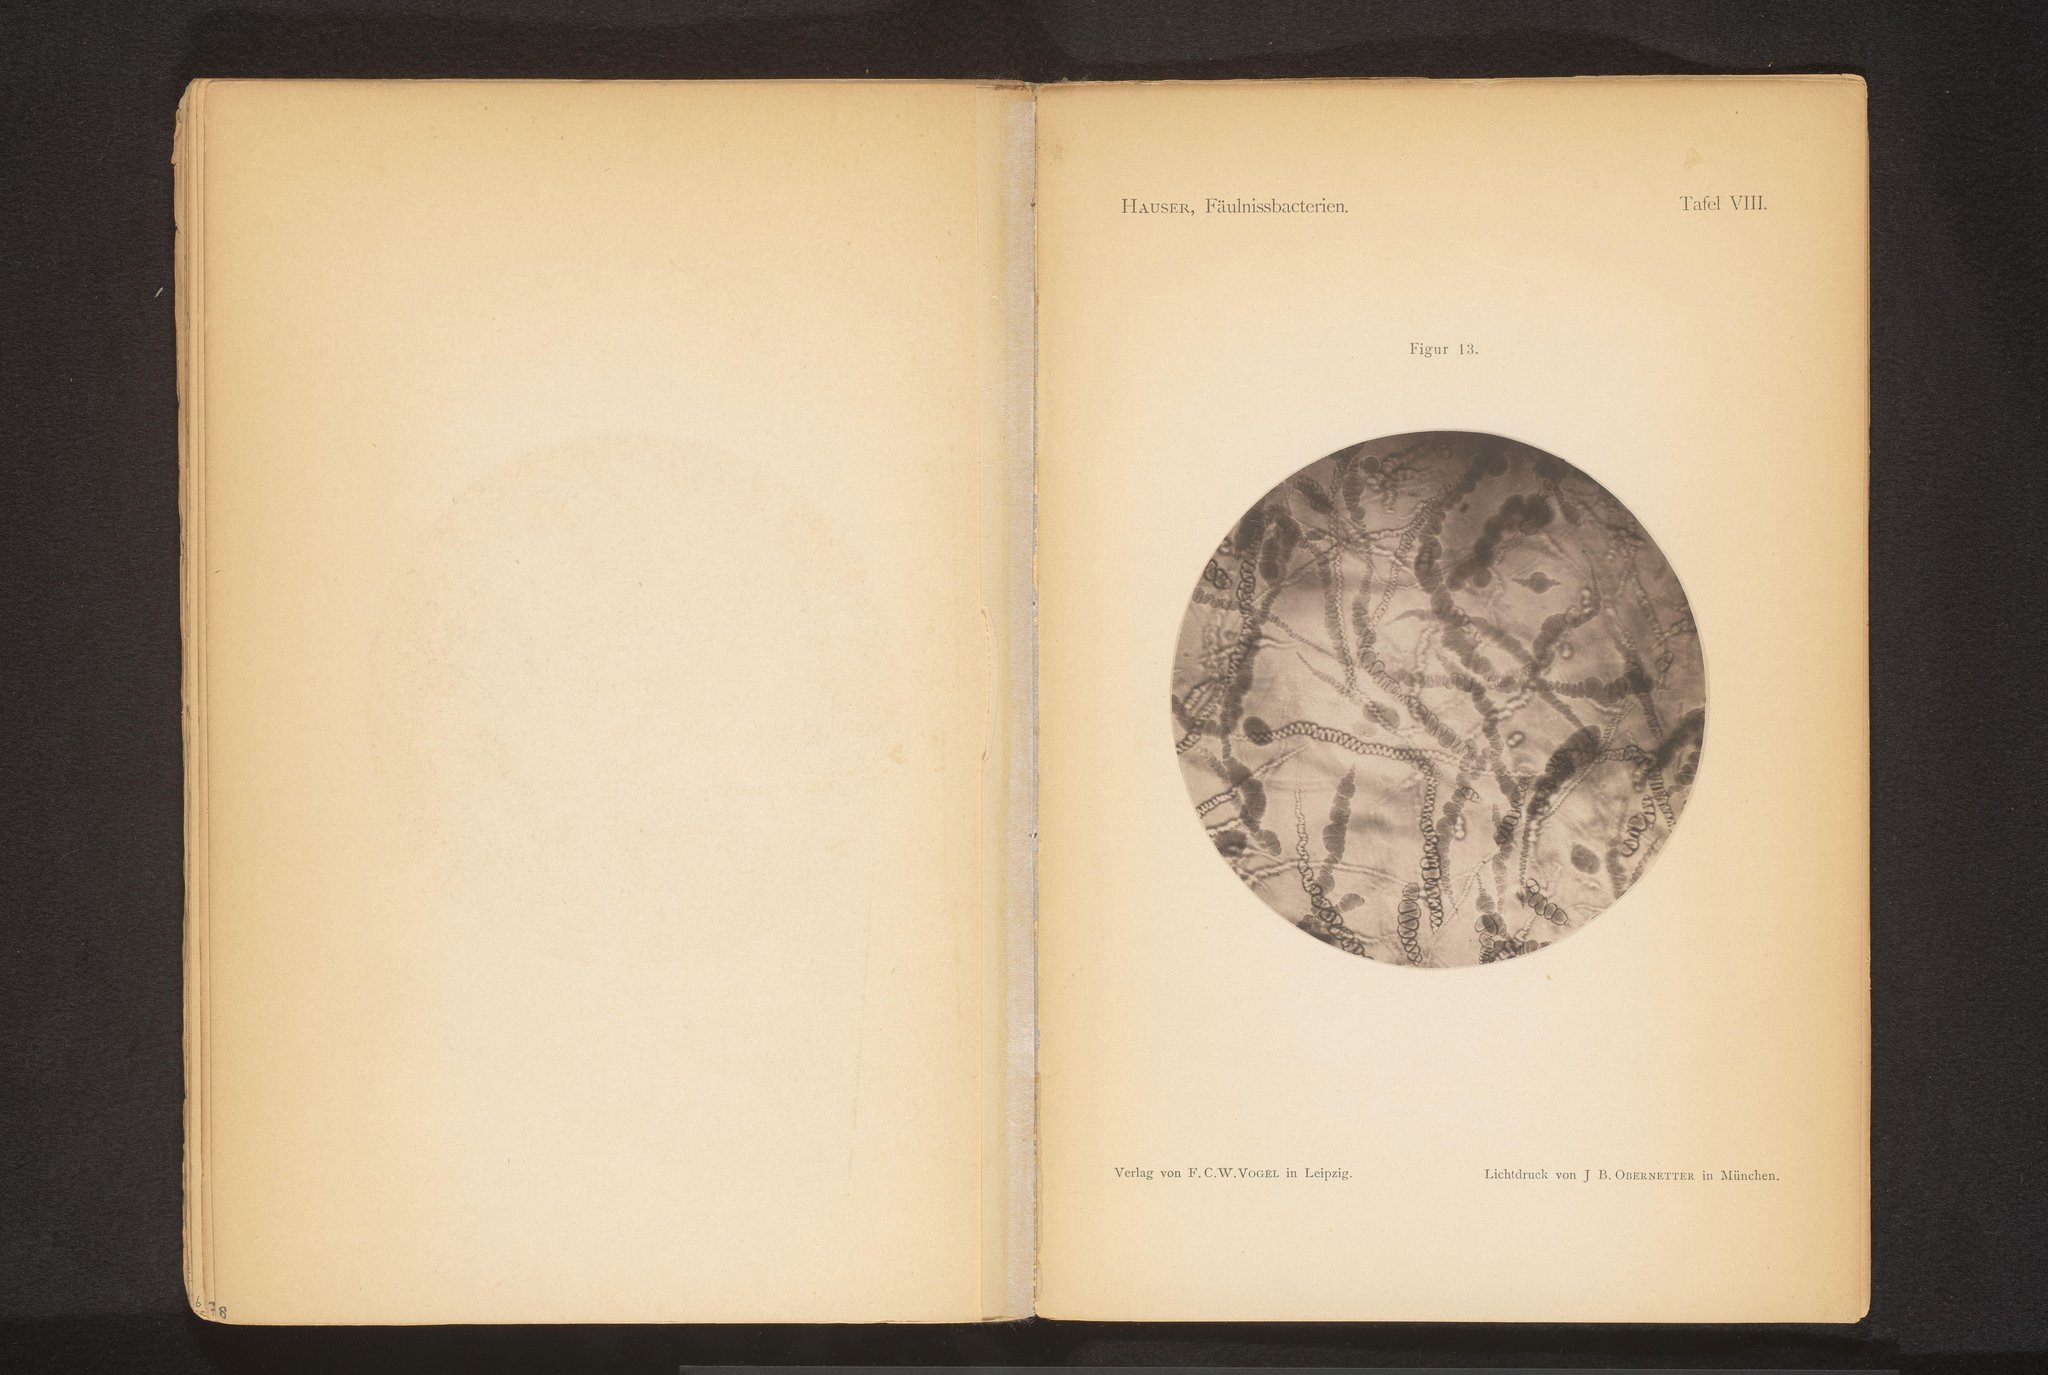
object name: photomechanical print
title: Microscoopopname van bederfbacteriën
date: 1875-1885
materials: paper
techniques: photograph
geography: leipzig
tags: unicellular animals, bacteria, bacilli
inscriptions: number: ‘Tafel VIII. Figur 13.’